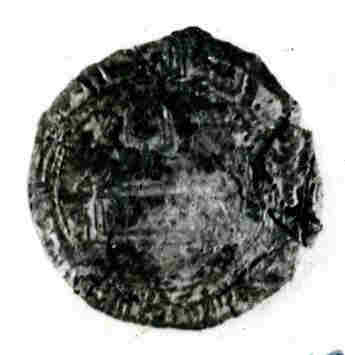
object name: coin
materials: copper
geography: iran